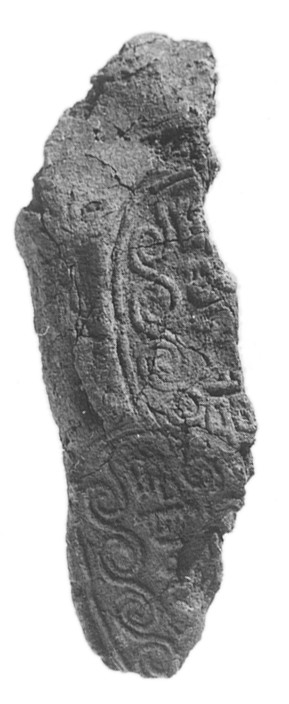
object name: sealing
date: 2030-1640 BCE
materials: clay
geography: egypt